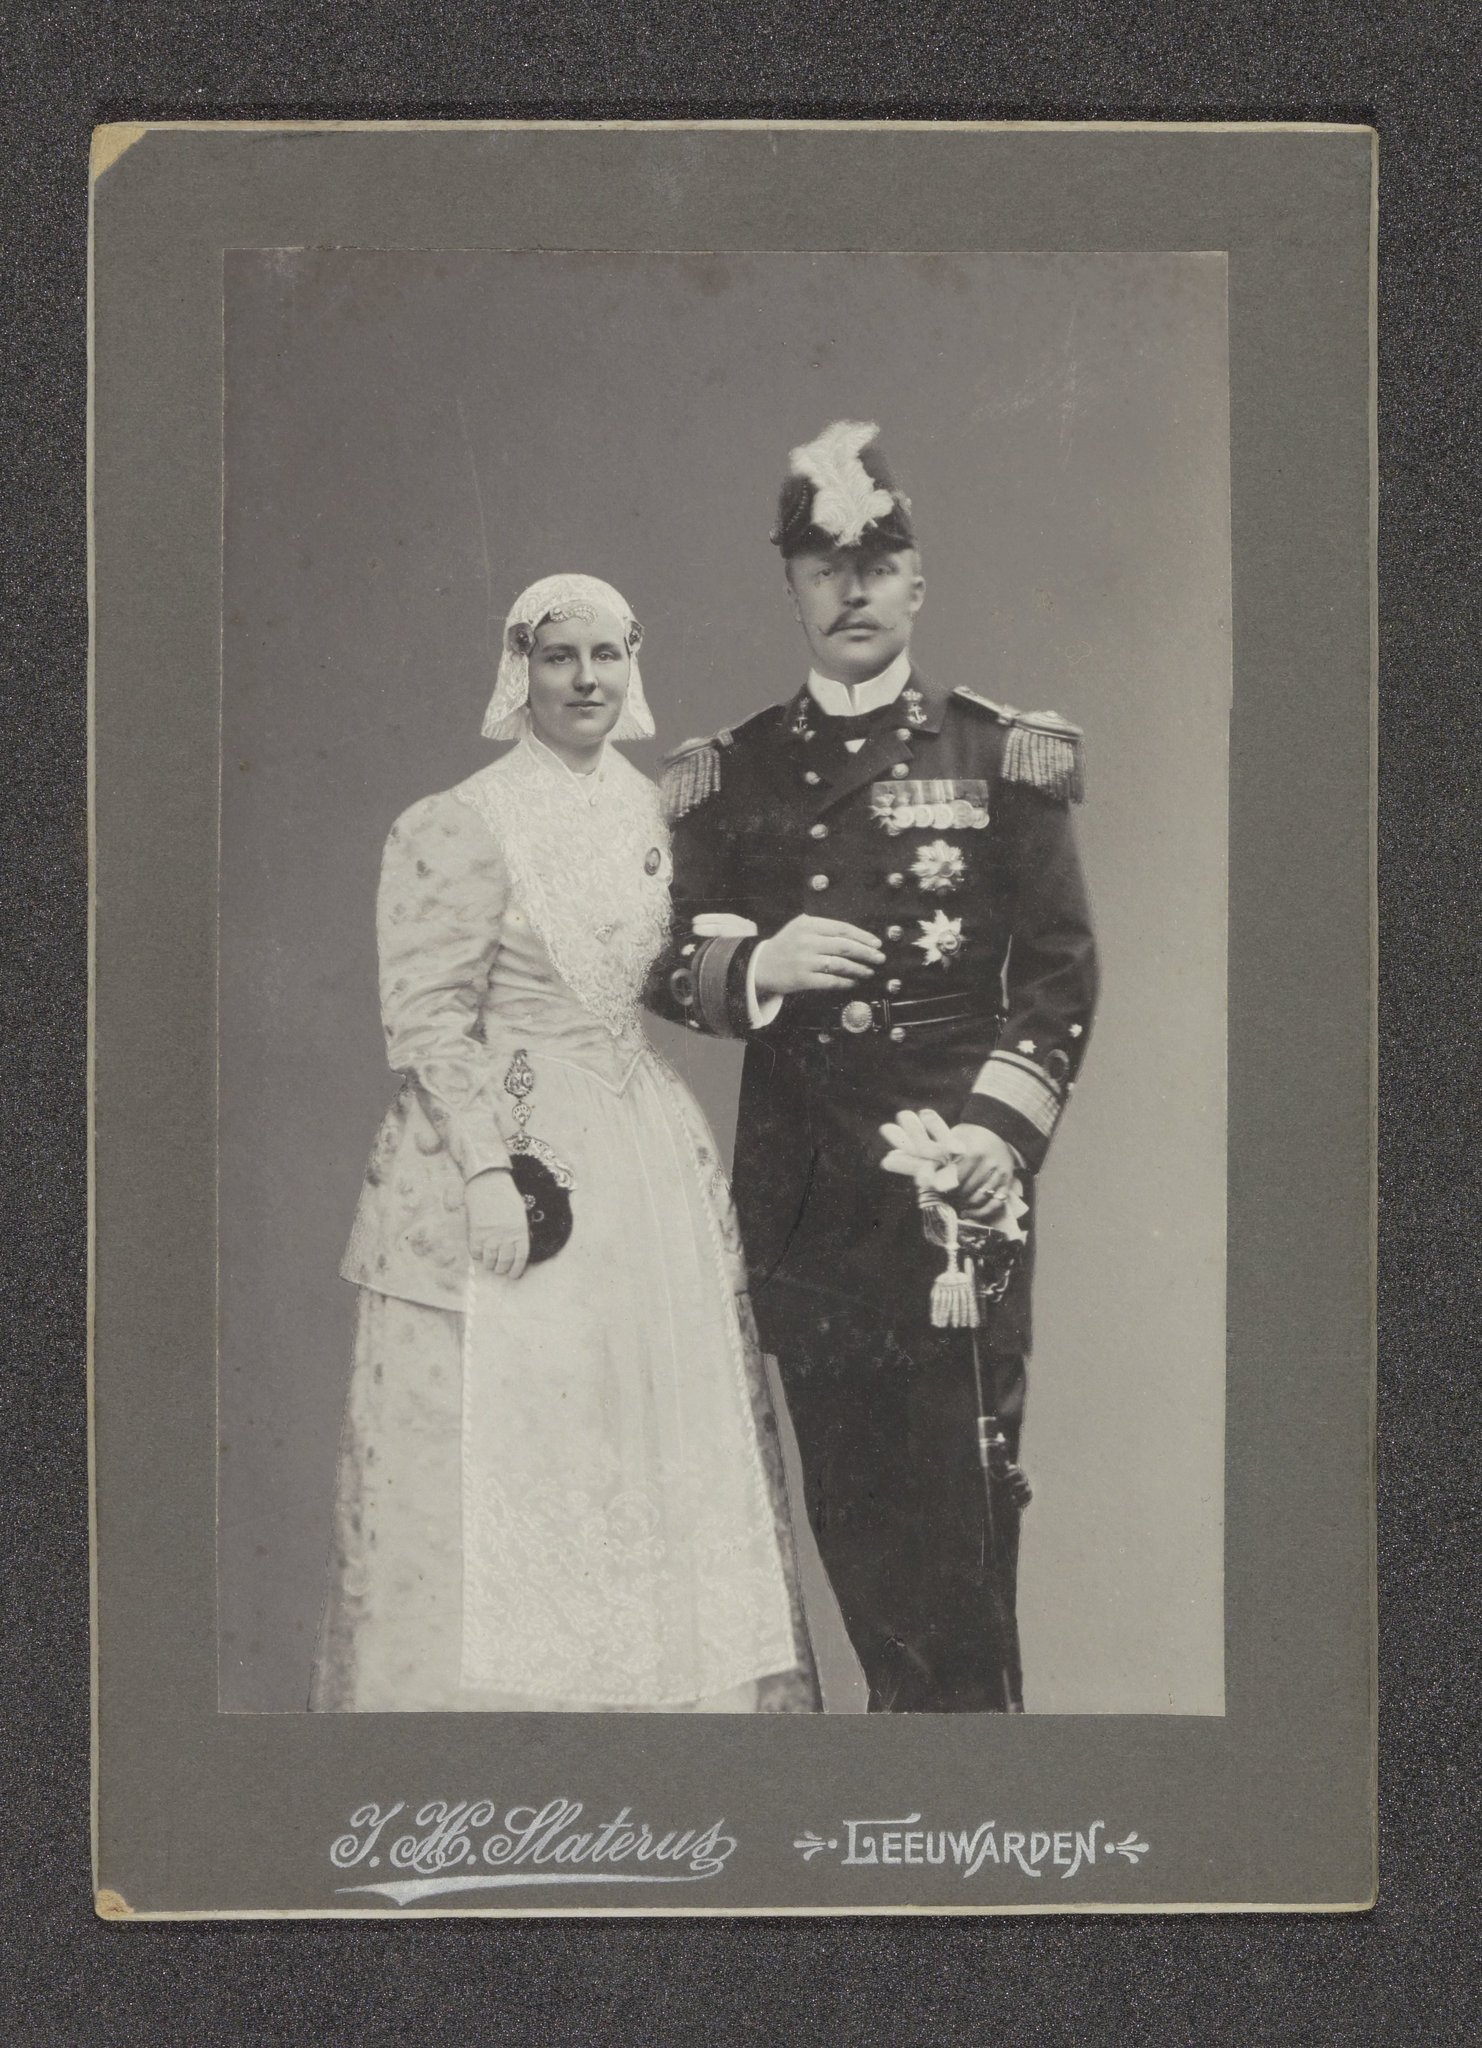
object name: photograph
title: Portret van een jonge koningin Wilhelmina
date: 1890-1910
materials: cardboard, photographic support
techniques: gelatin silver print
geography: amsterdam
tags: the hague, print maker, wilhelmina of the netherlands